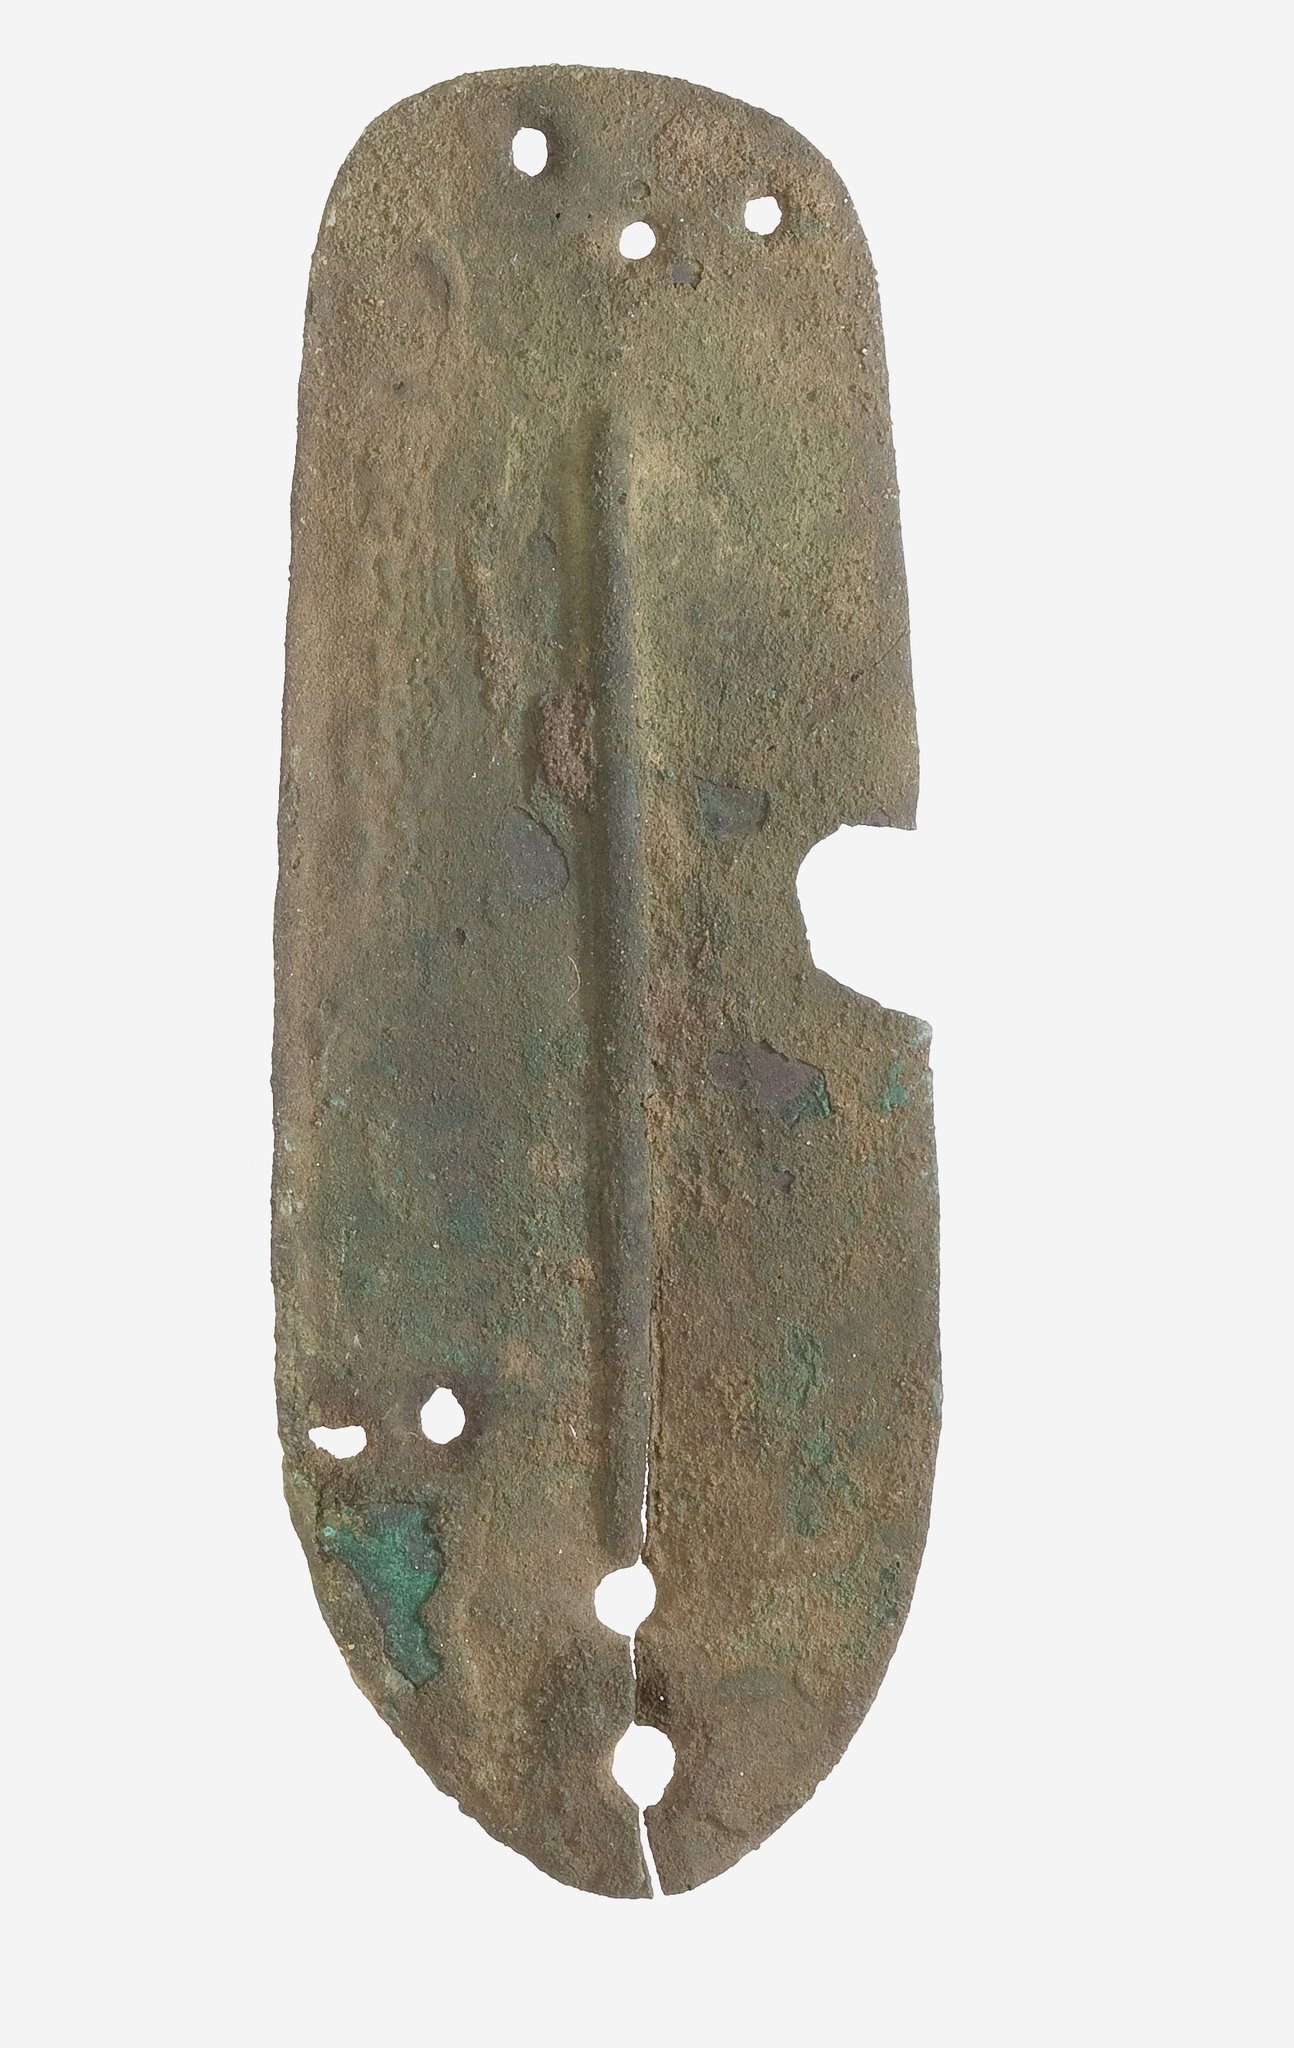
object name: armor scale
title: Scale from Armor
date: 1390-1352 BCE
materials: bronze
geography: egypt